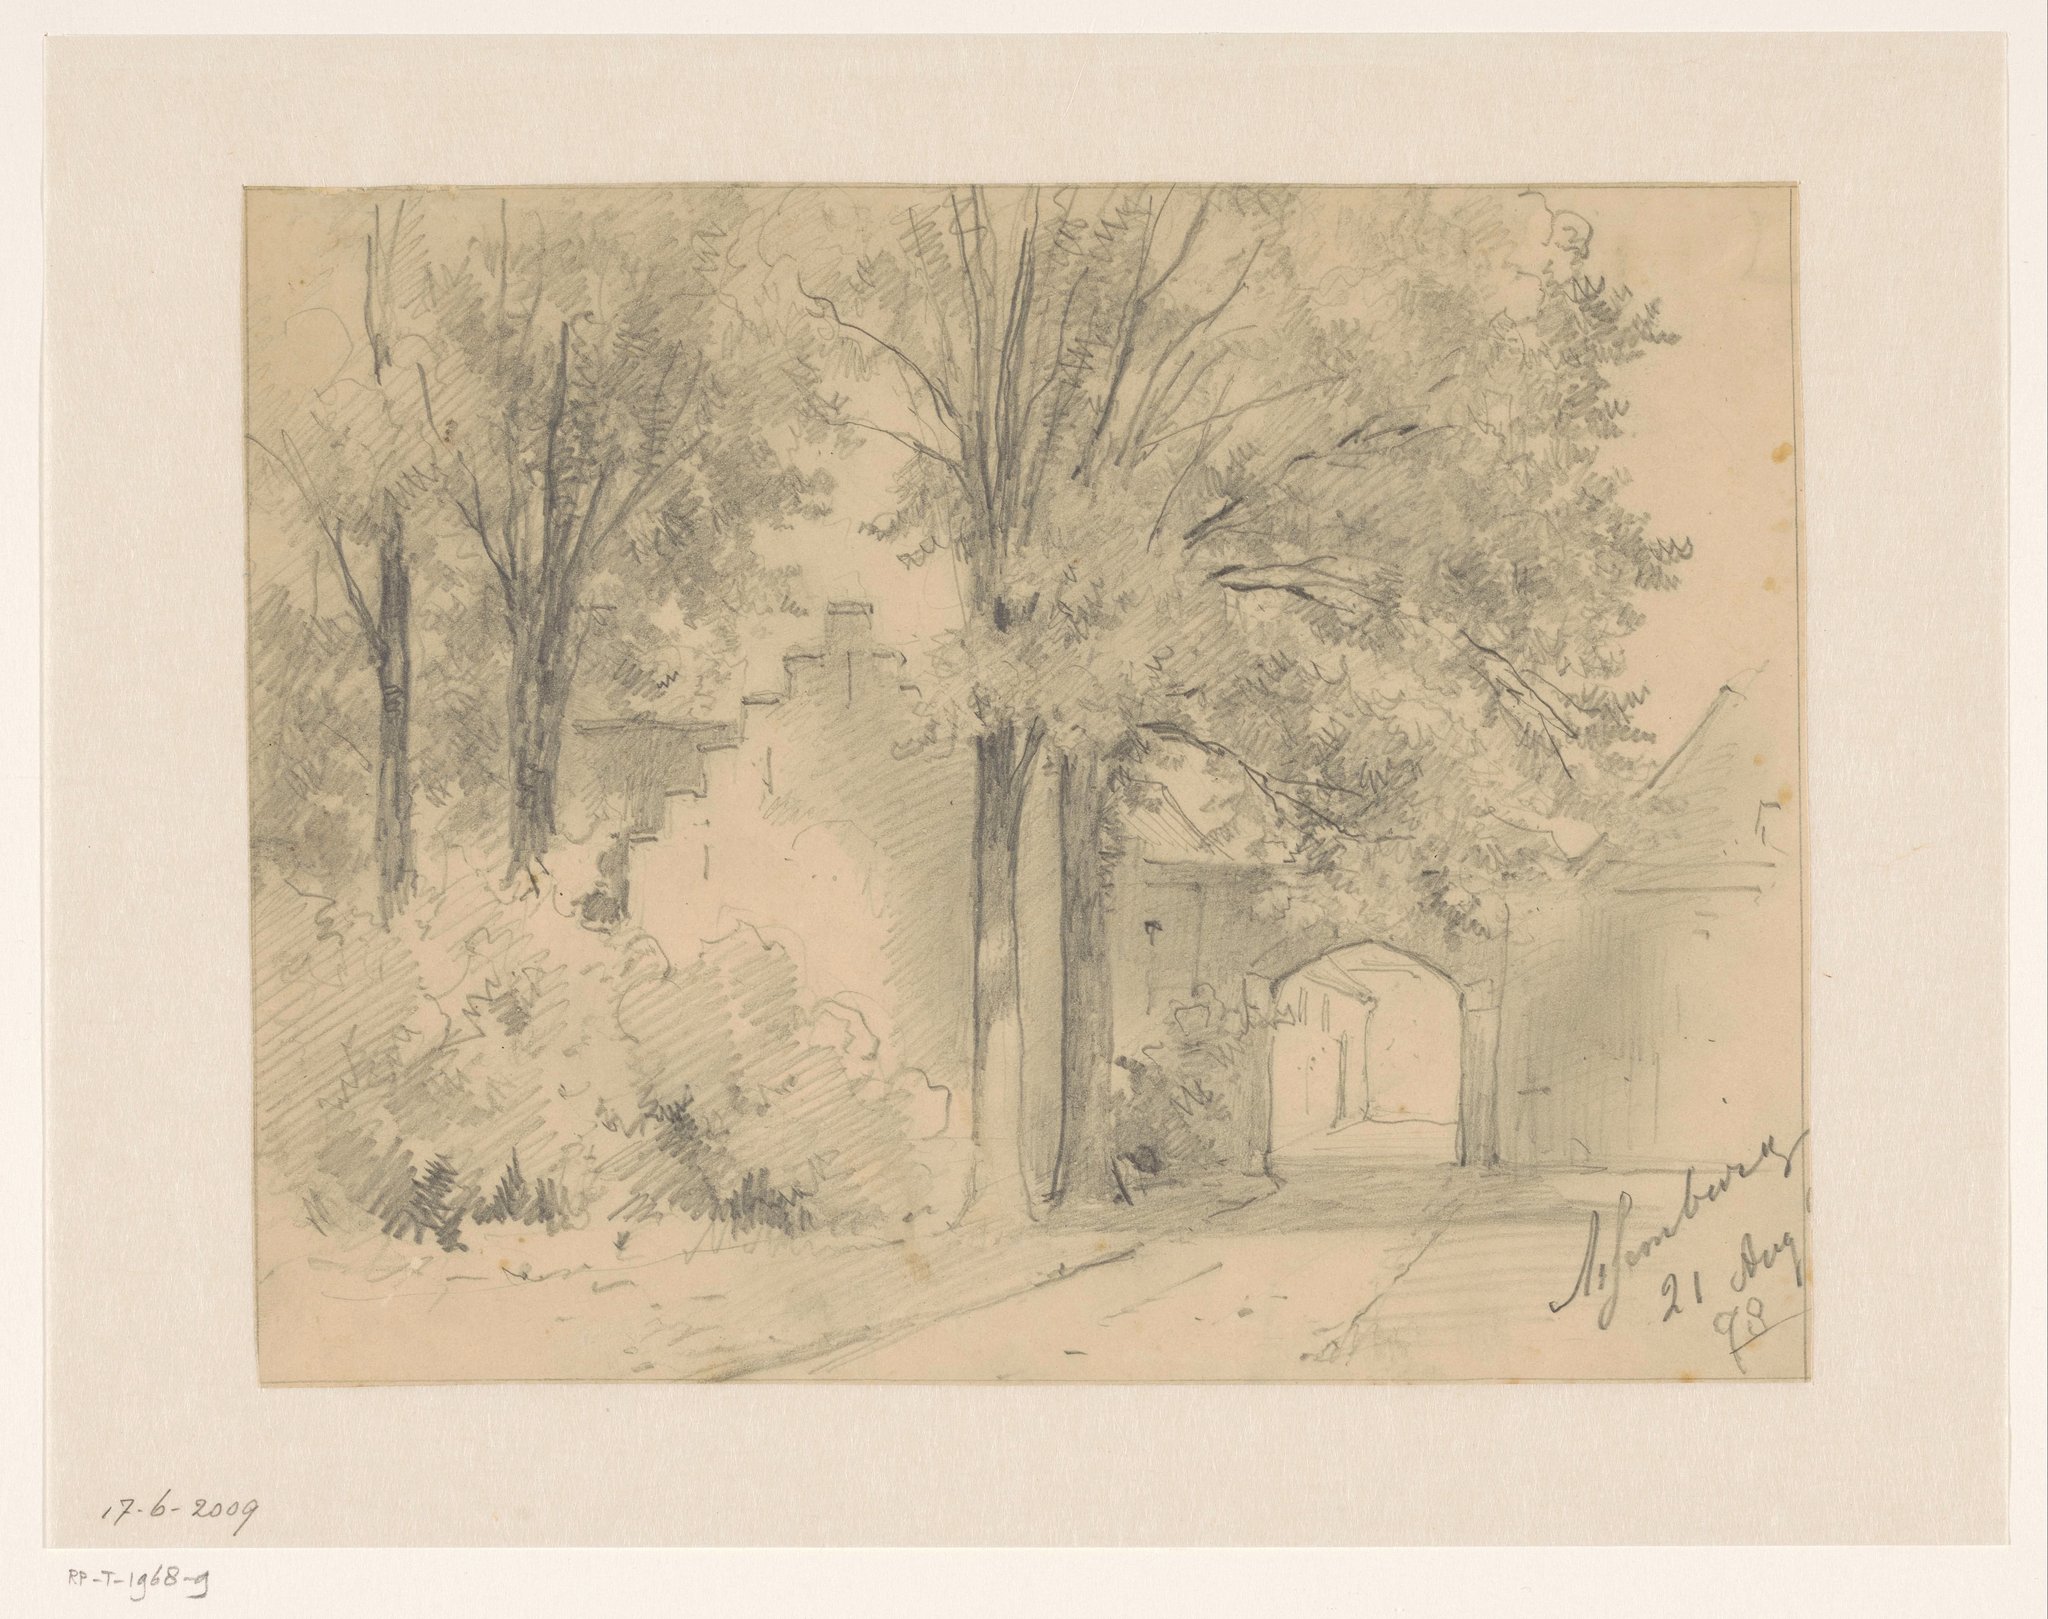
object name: drawing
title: Poort van het kasteel Assemburg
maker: jan striening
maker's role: draughtsman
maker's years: 1827-1903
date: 1898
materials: paper, pencil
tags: switchback, scenic railway, castle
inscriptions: date: ‘21 Aug 98’